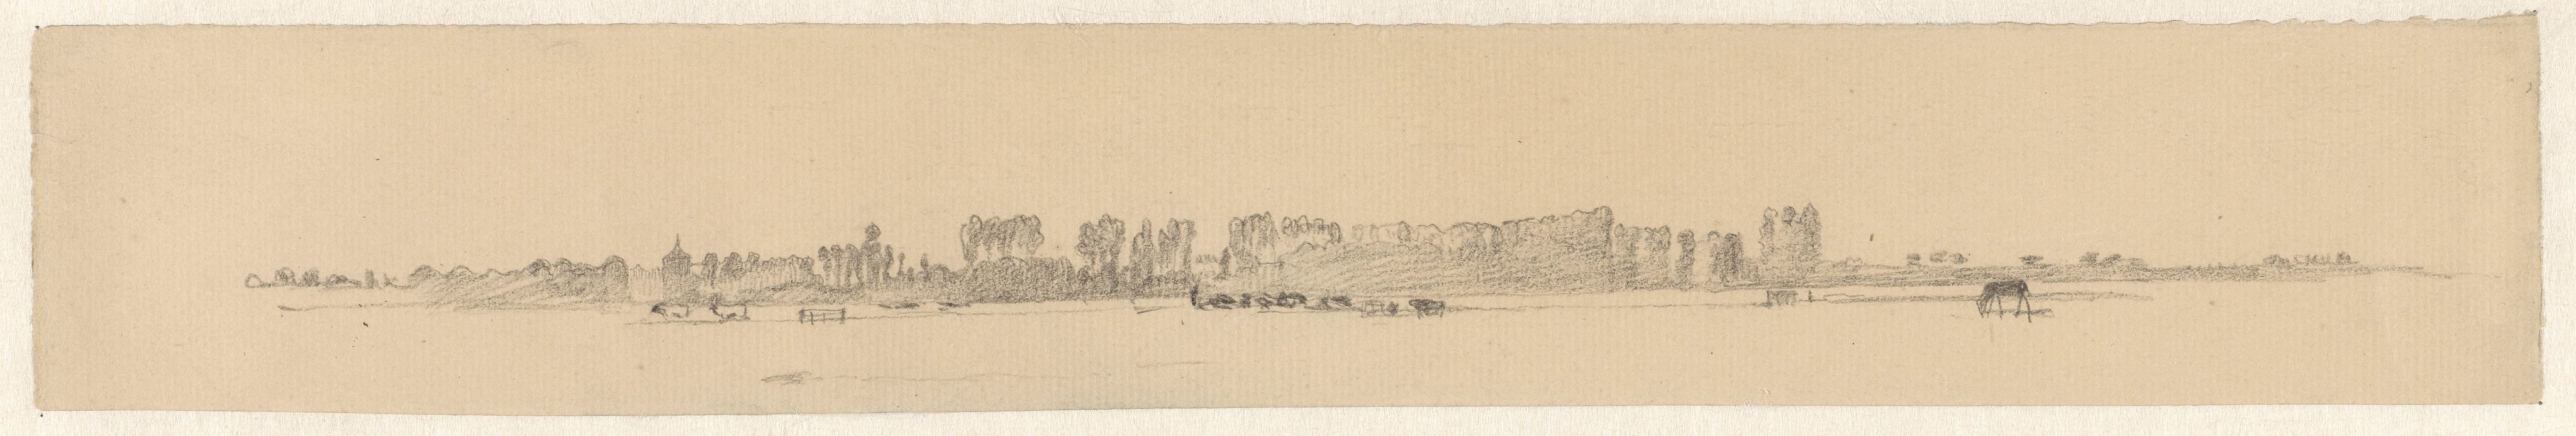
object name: drawing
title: Duinlandschap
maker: guillaume anne van der brugghen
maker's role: draughtsman, print maker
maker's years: 1812-1891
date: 1821-1891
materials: paper, pencil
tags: dunes (sea not visible); in the dunes